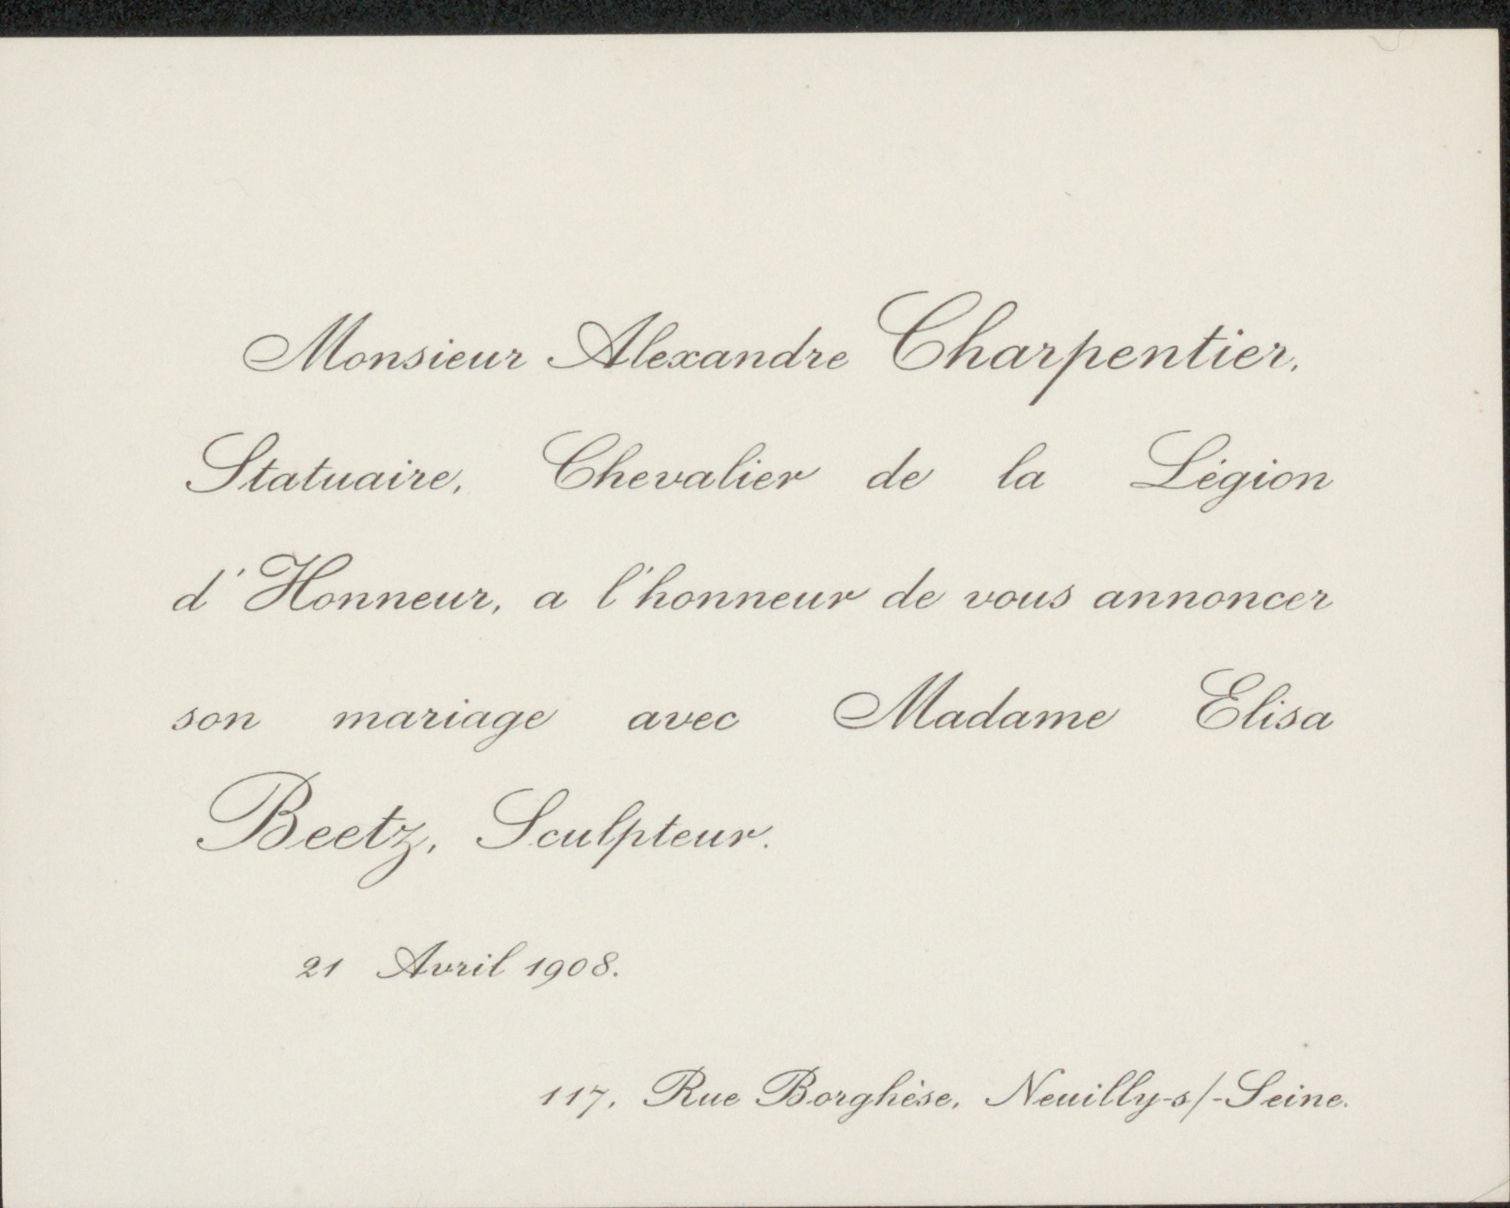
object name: wedding announcement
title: Huwelijksaankondiging aan Philip Zilcken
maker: Anonymous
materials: cardboard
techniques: printing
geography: france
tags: paris, print maker, alexandre louis marie charpentier, sculptor, elisa beetz, the hague, draughtsman, philip zilcken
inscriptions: collector's mark: ‘RPK’